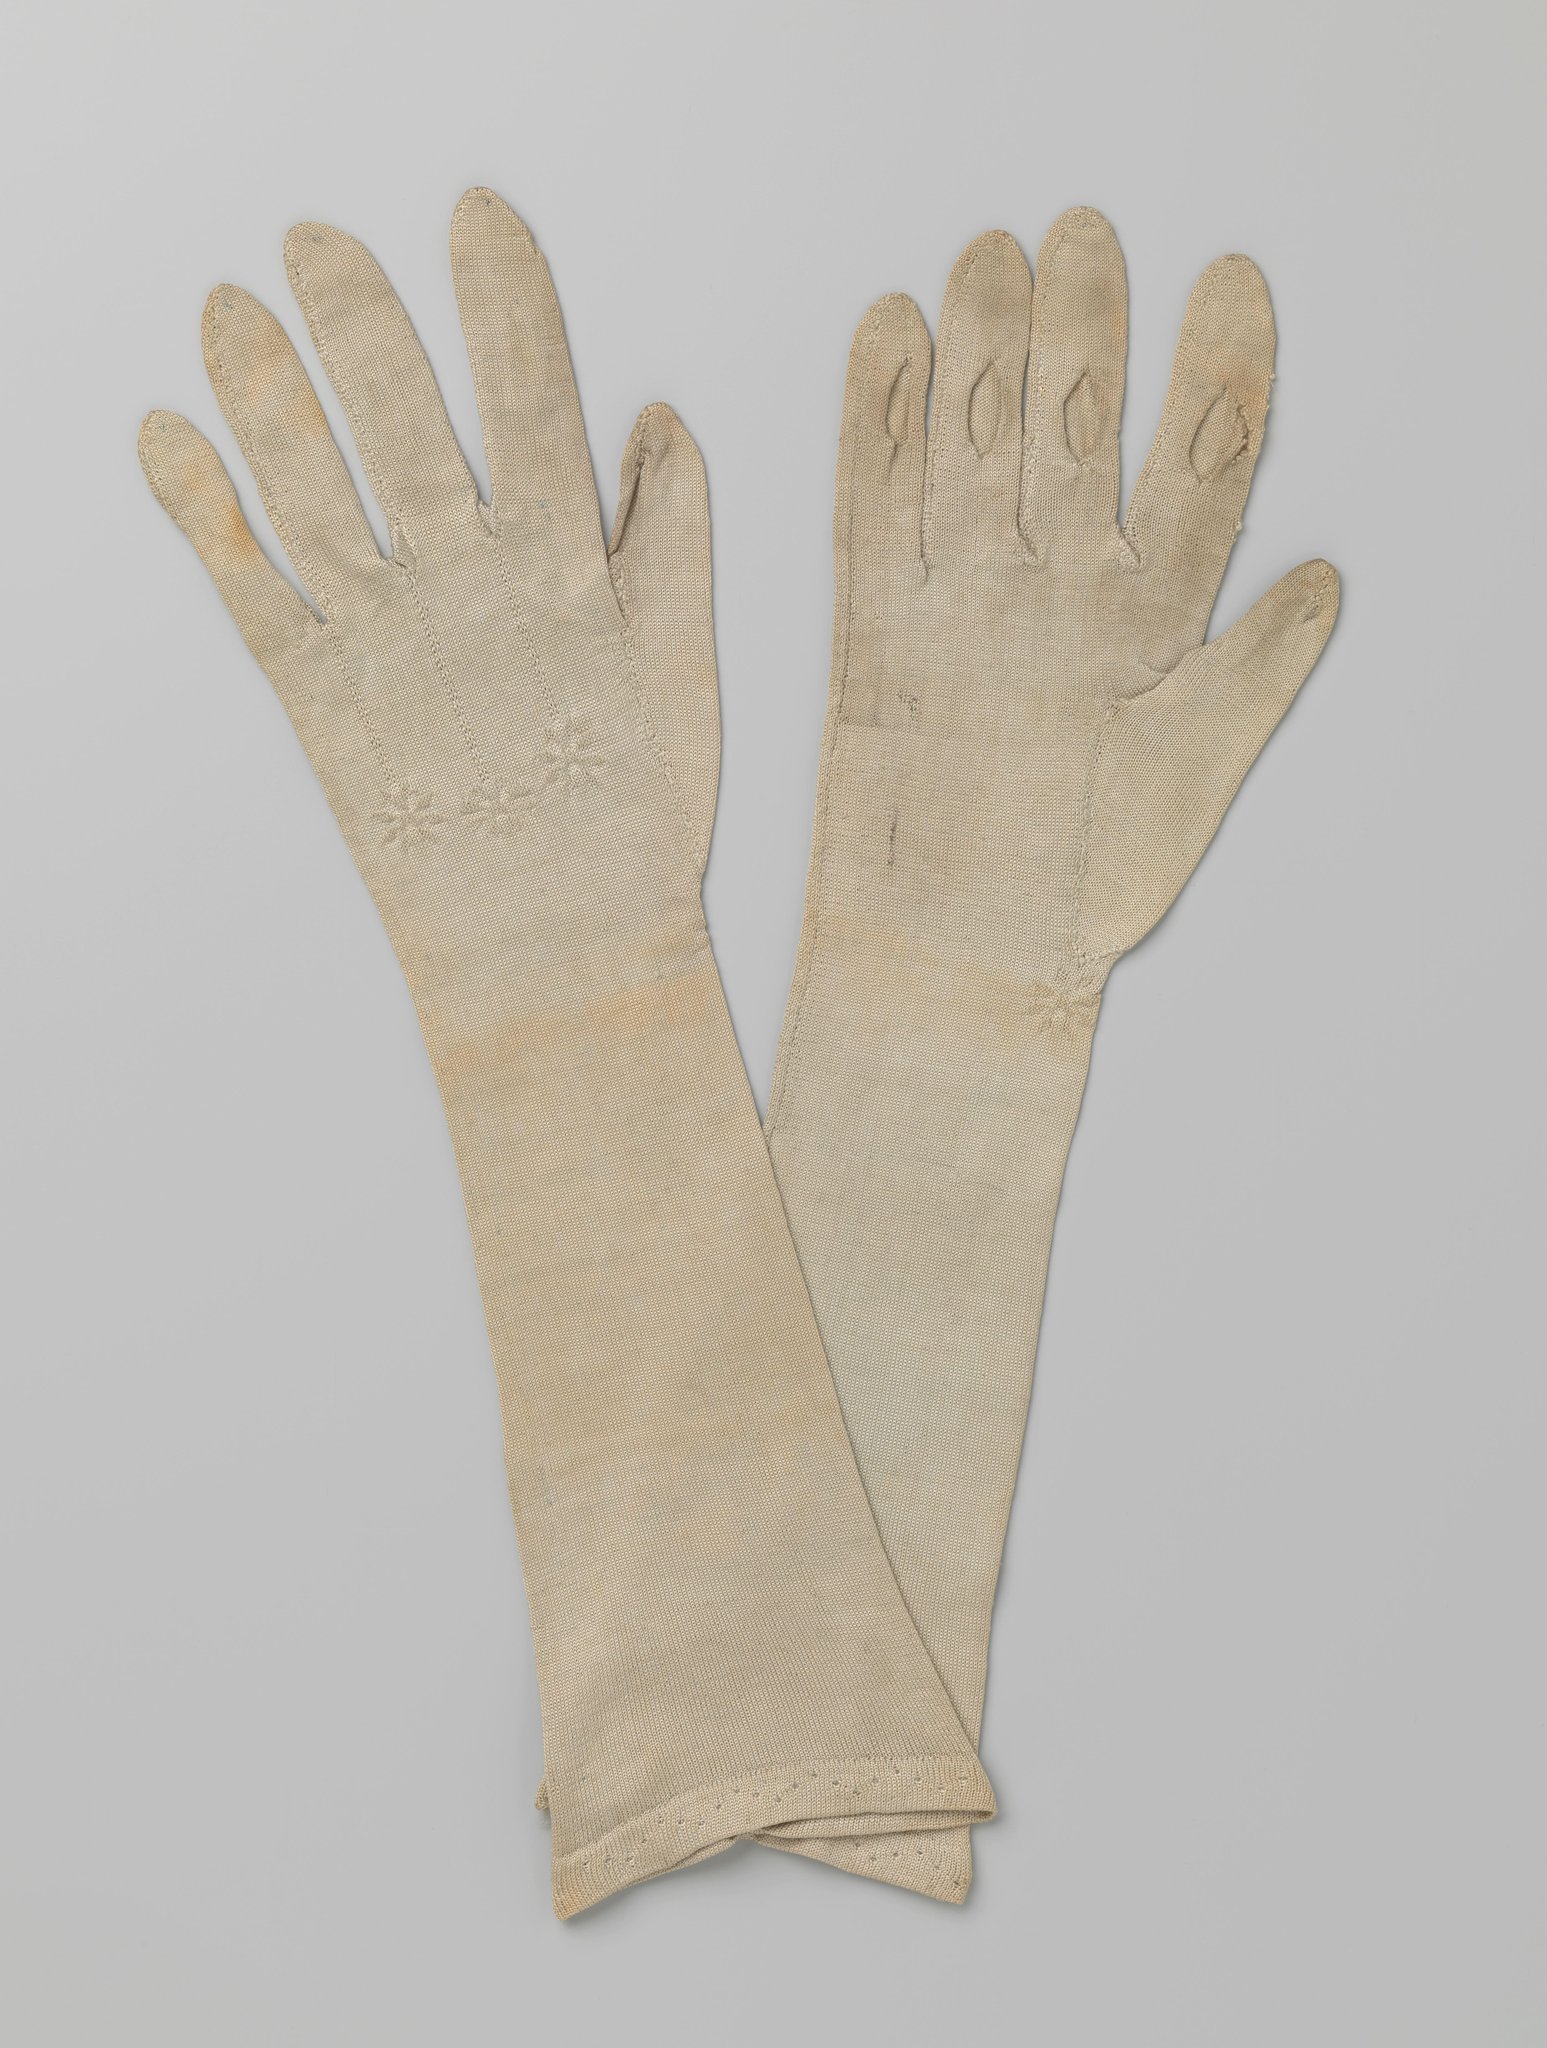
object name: glove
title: Handschoen van witte gebreide zijde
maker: Anonymous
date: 1800-1850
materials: silk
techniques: knitting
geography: netherlands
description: Rechterhandschoen van witte zijde, met ovaalvormige openingen aan de binnenzijden van de vingertoppen, op de rug drie uitstralende koorden eindigend in bloemen.